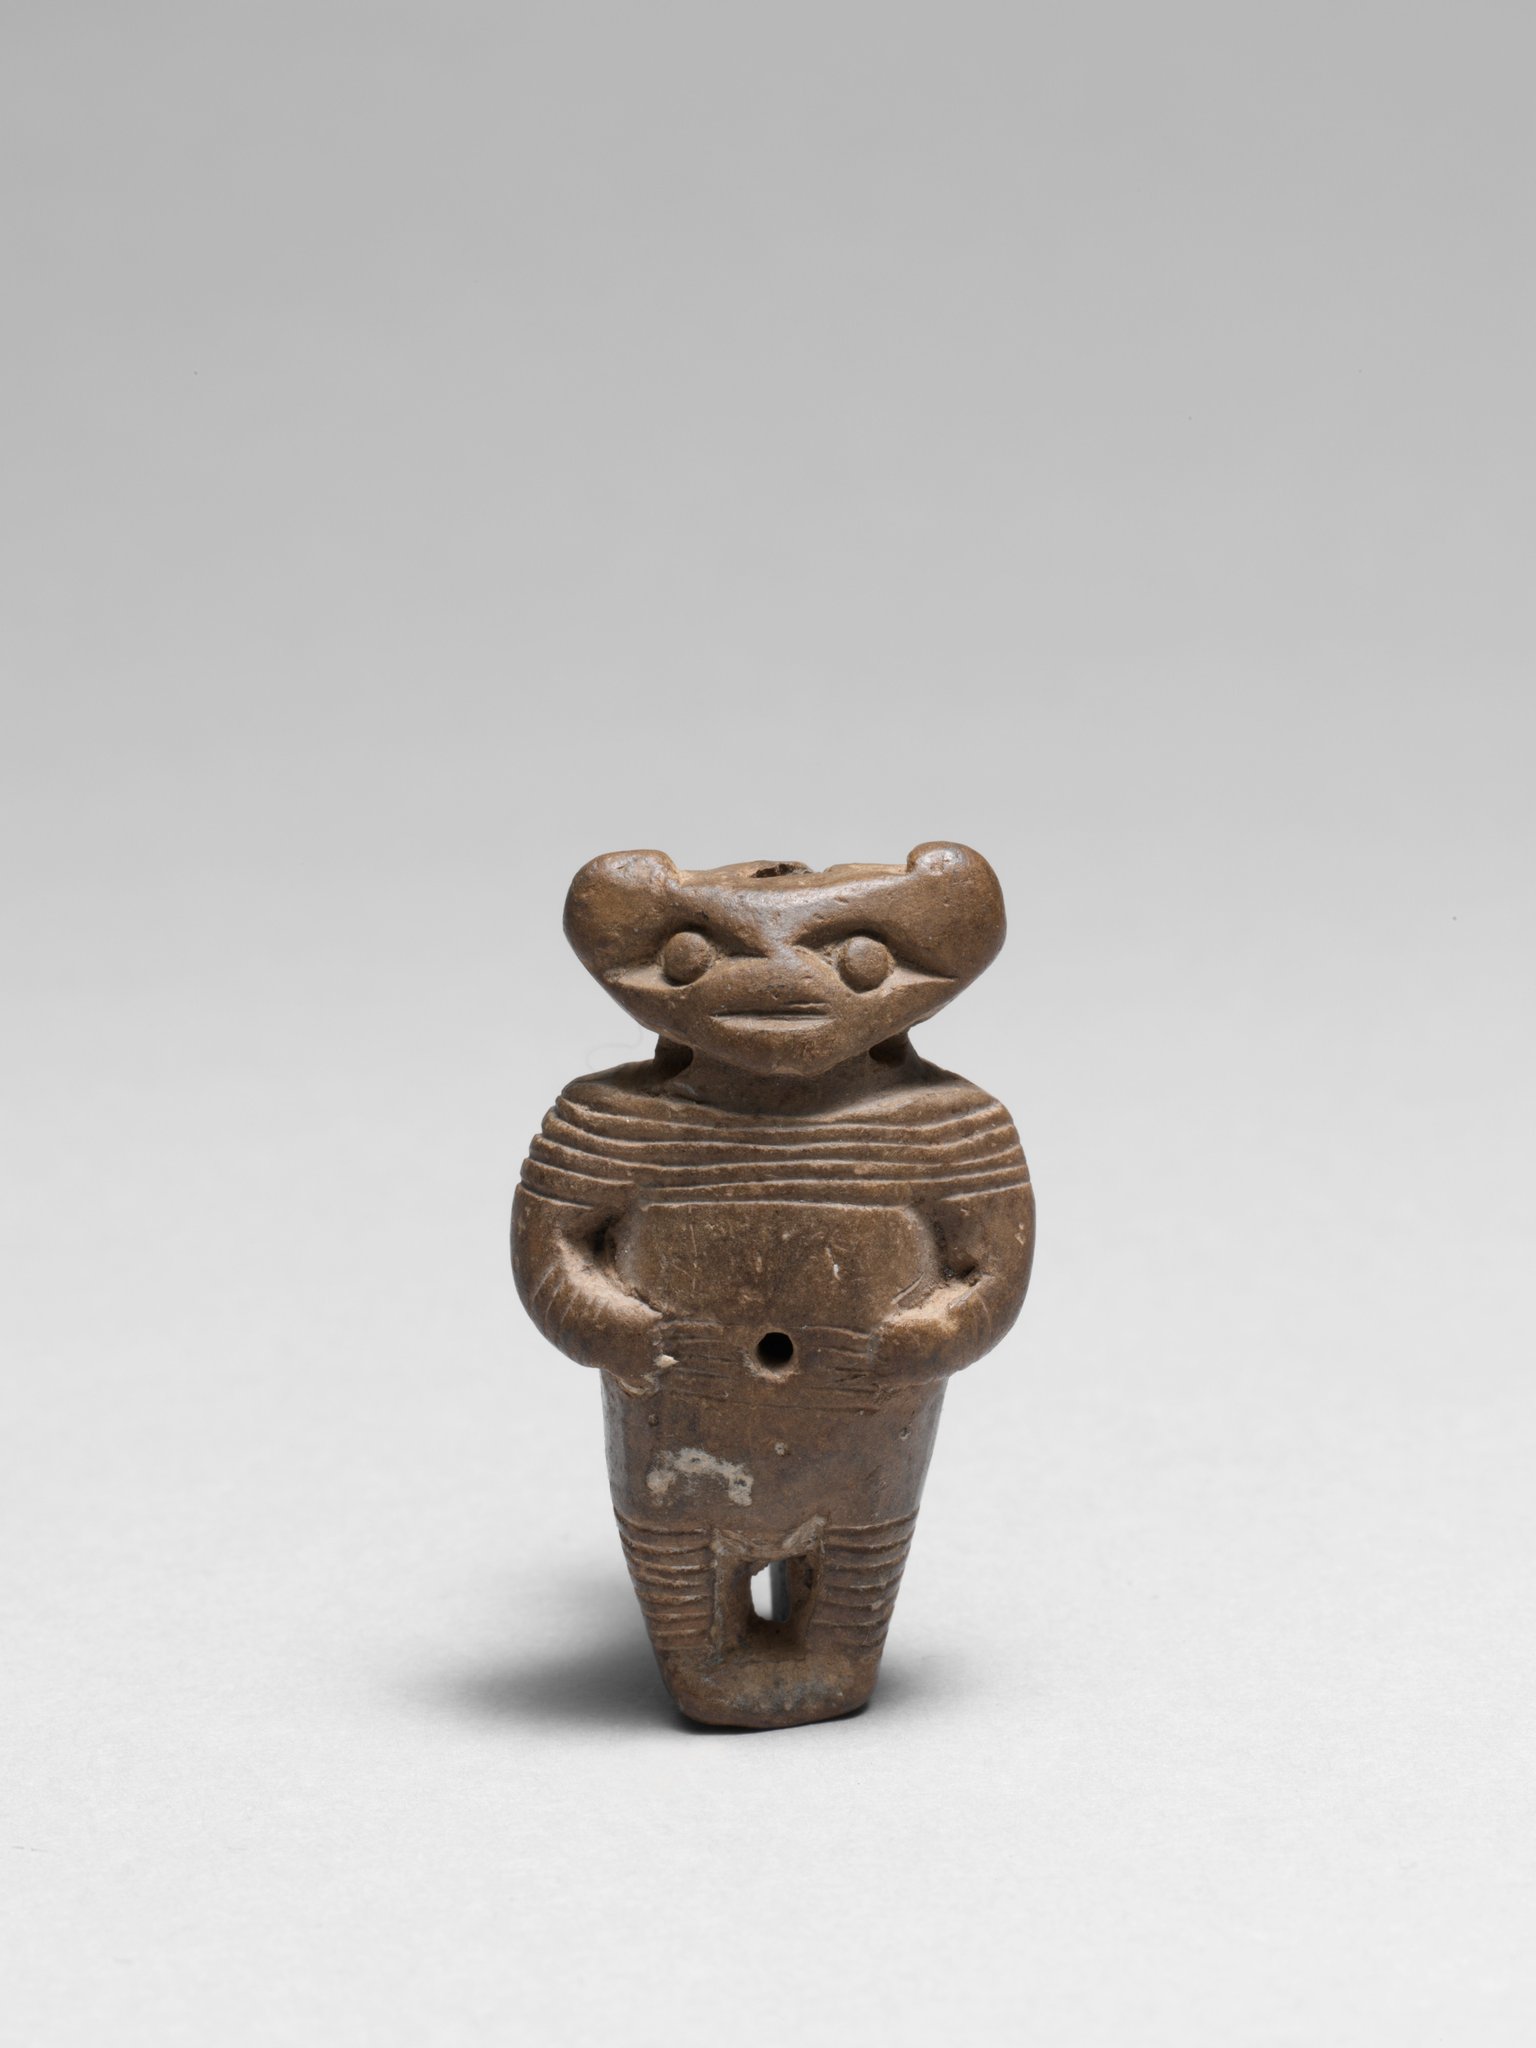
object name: pottery whistle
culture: tairona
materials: clay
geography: colombia